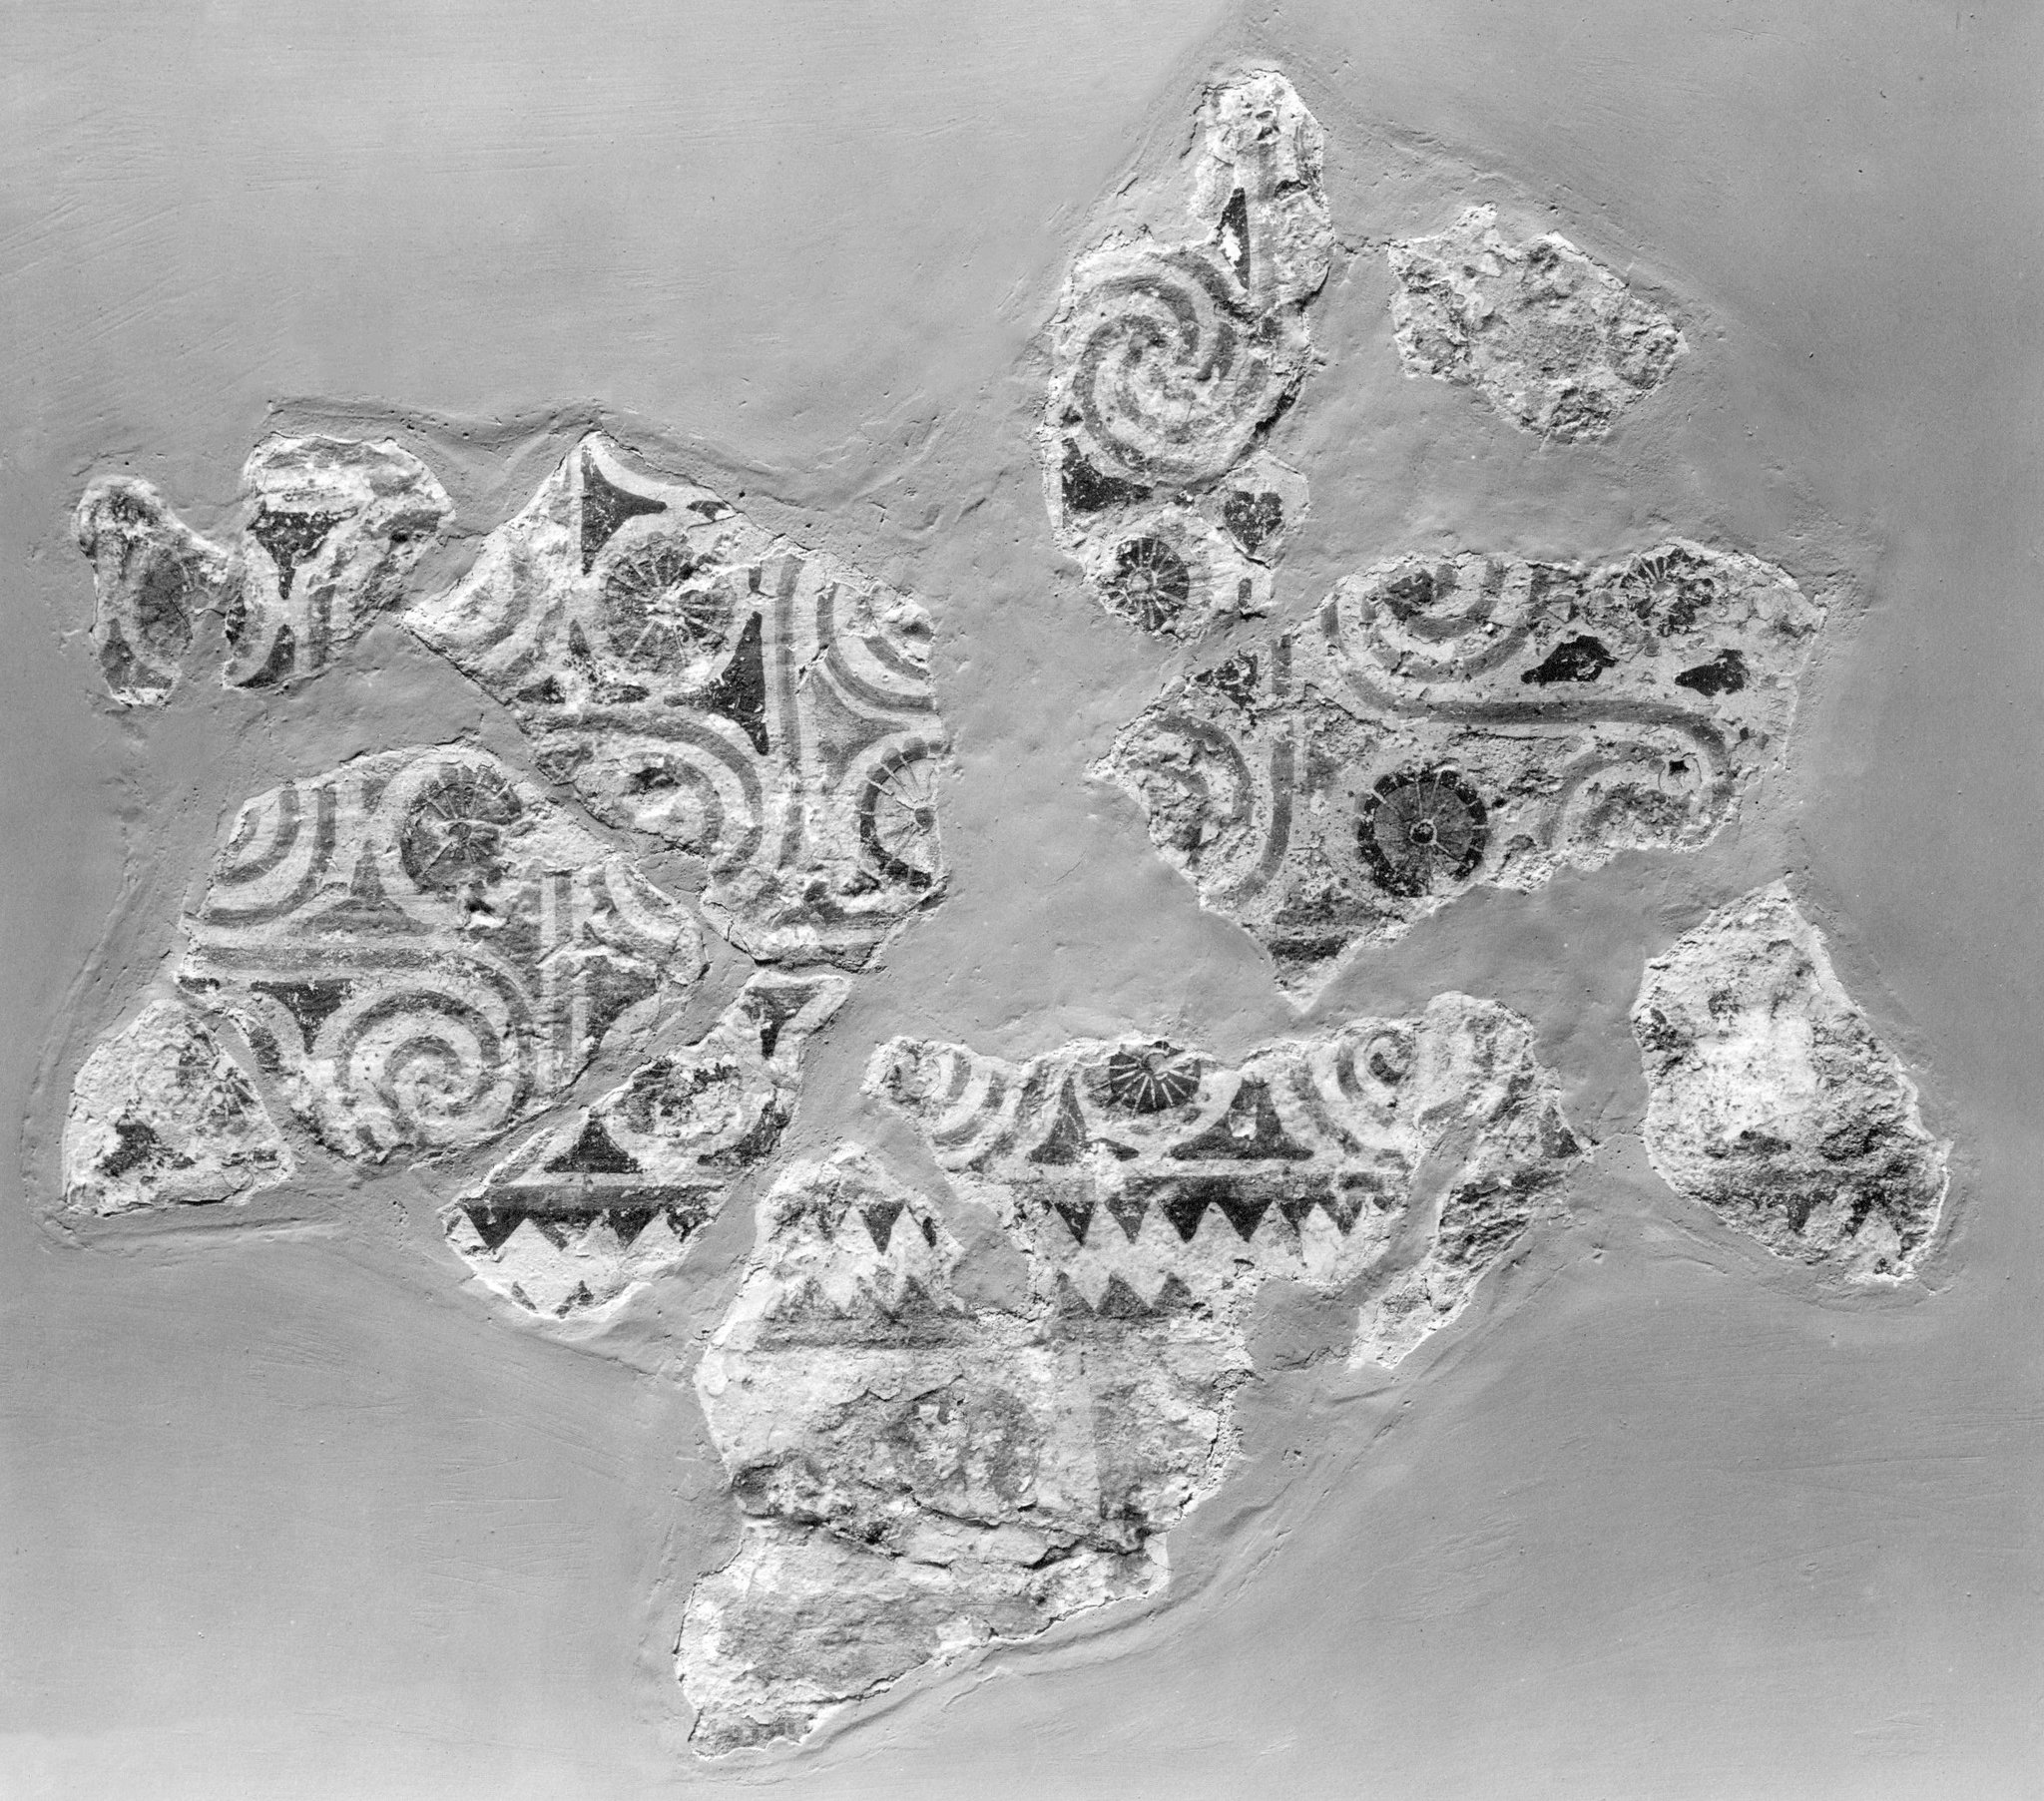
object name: ceiling painting, senenmut, tt 71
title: Ceiling Painting from the Tomb Chapel of Senenmut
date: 1479-1458 BCE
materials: mud, paint, plaster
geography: egypt